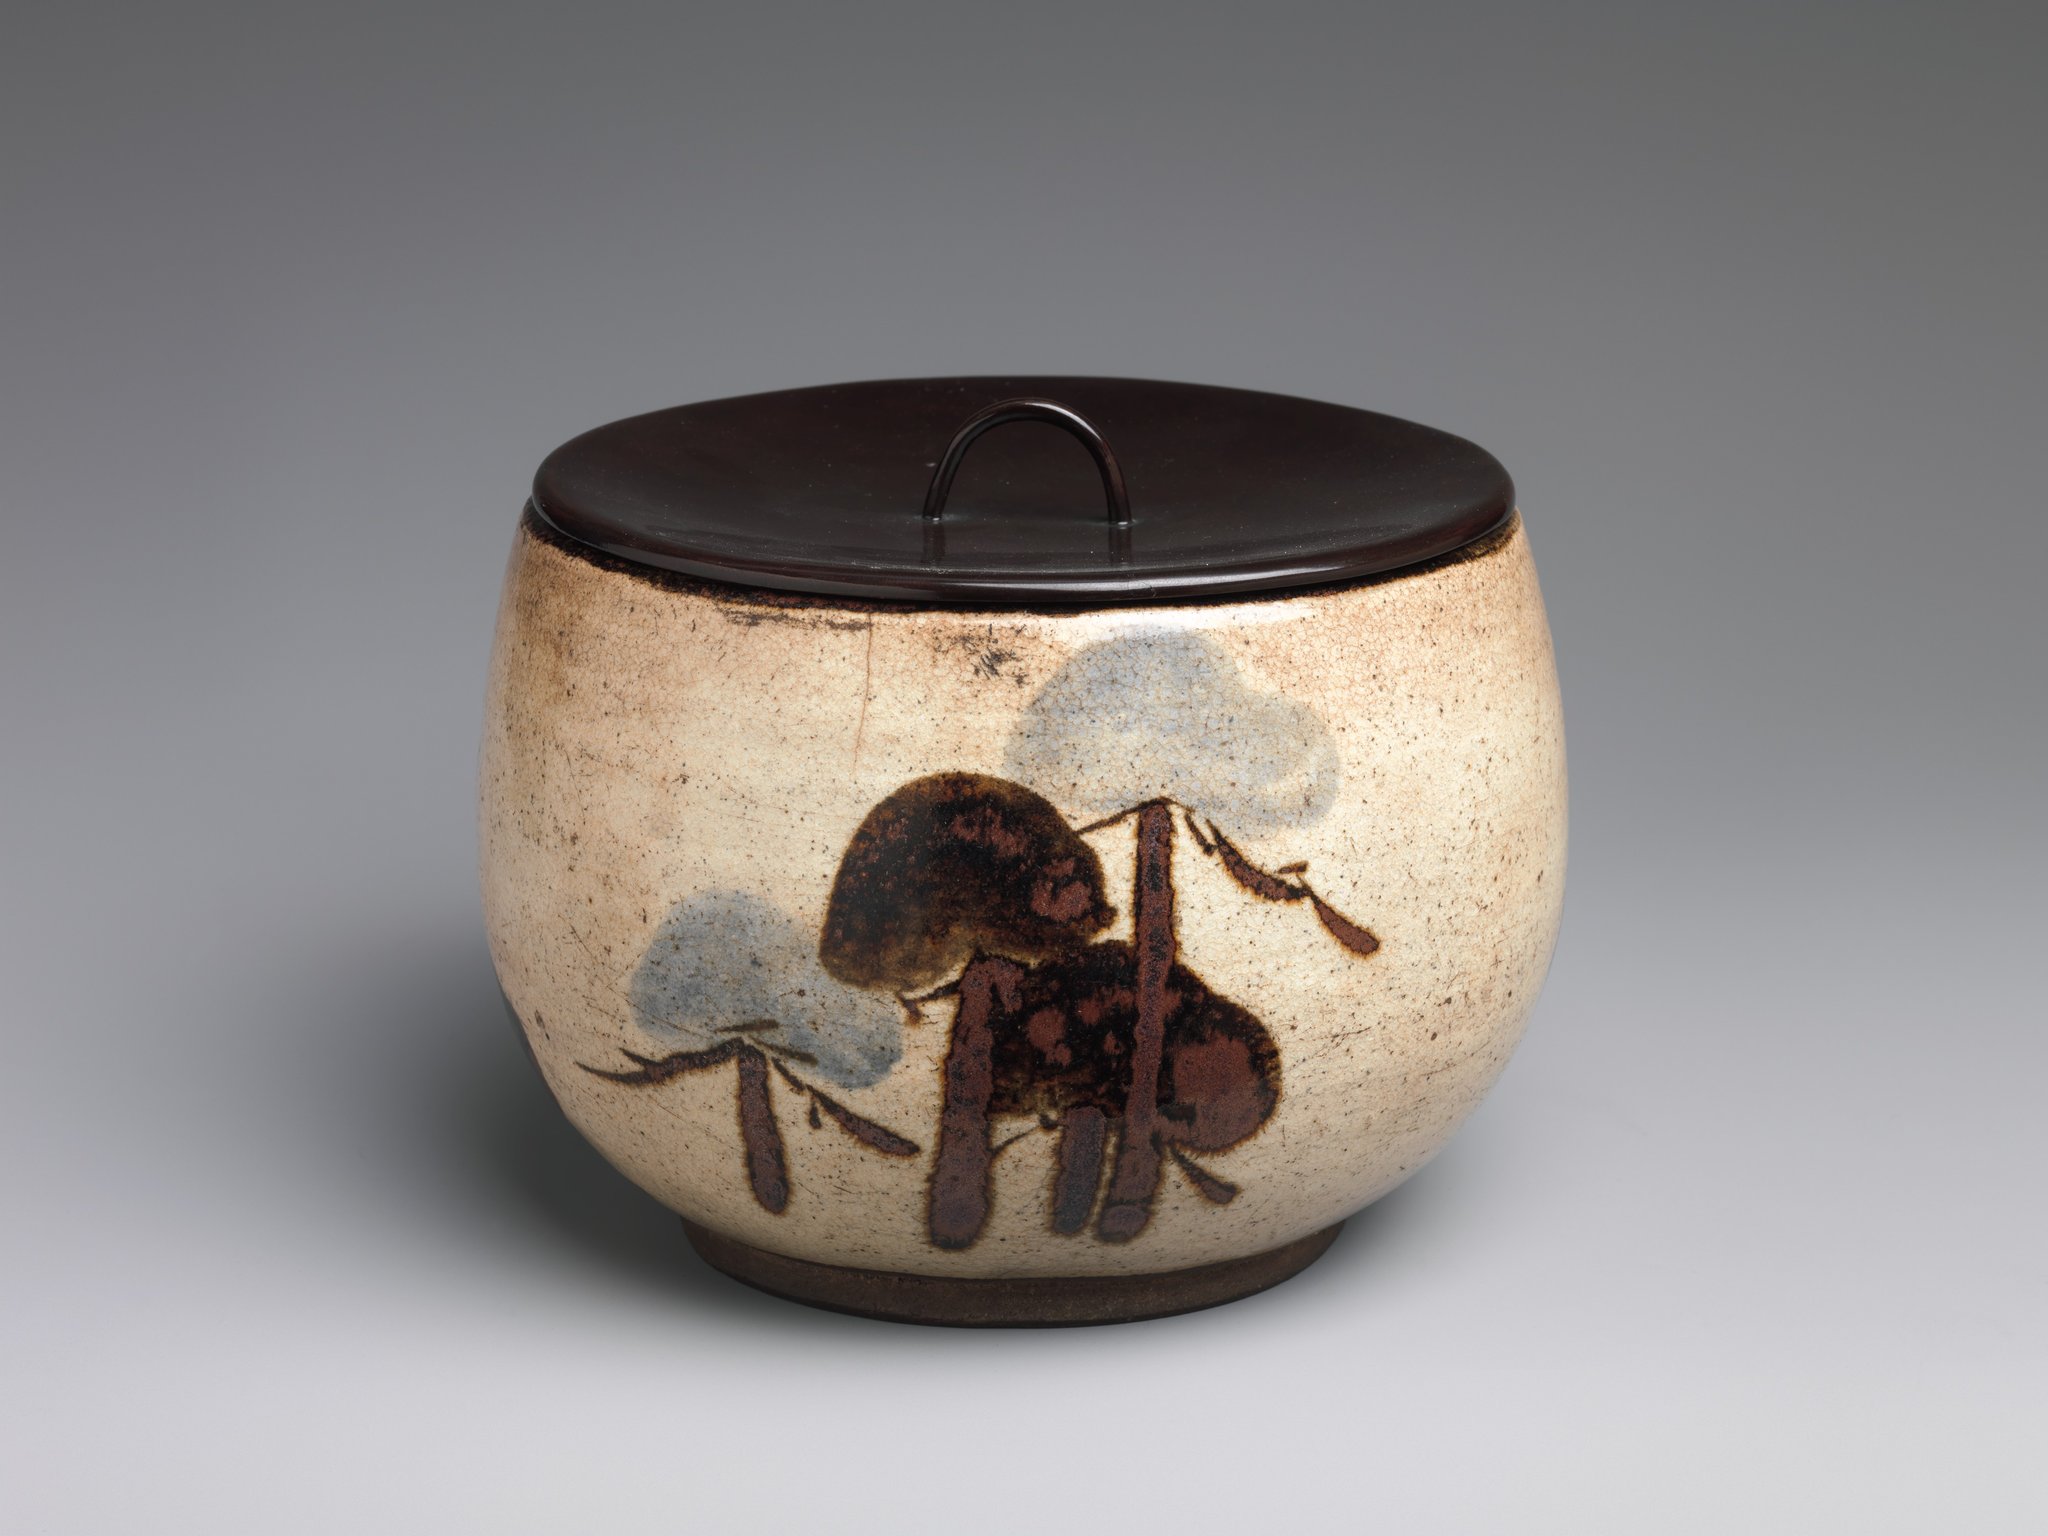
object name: jar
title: Water Jar (Mizusashi) with Pine Trees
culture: japanese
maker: ogata kenzan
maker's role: artist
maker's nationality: japanese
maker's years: 1663-1743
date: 1720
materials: iron, lacquer, stoneware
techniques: underglaze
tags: trees